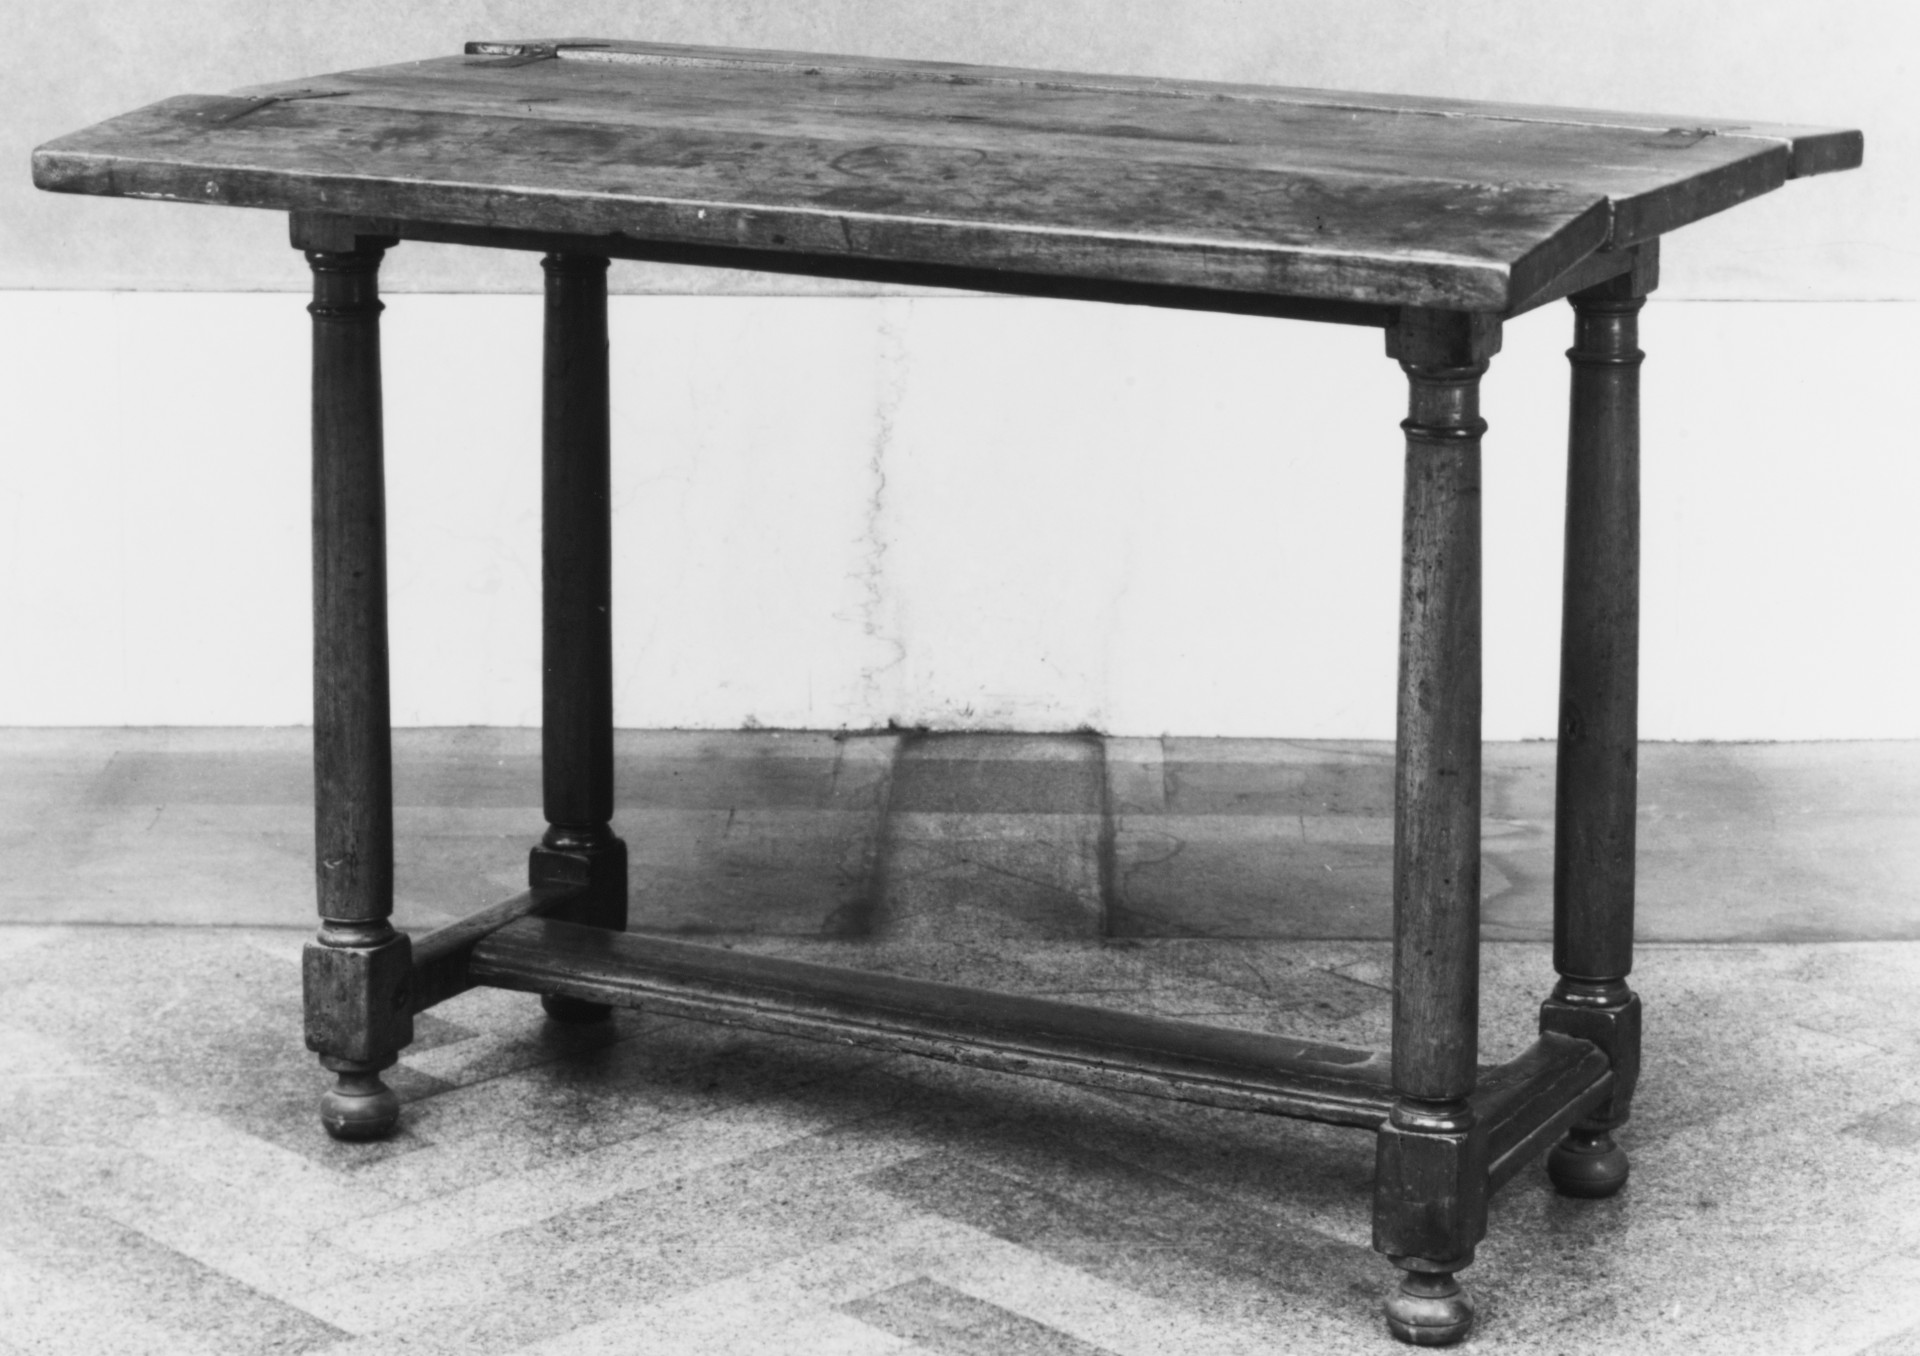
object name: drop leaf table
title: Drop-leaf table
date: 1567-1633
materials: wood